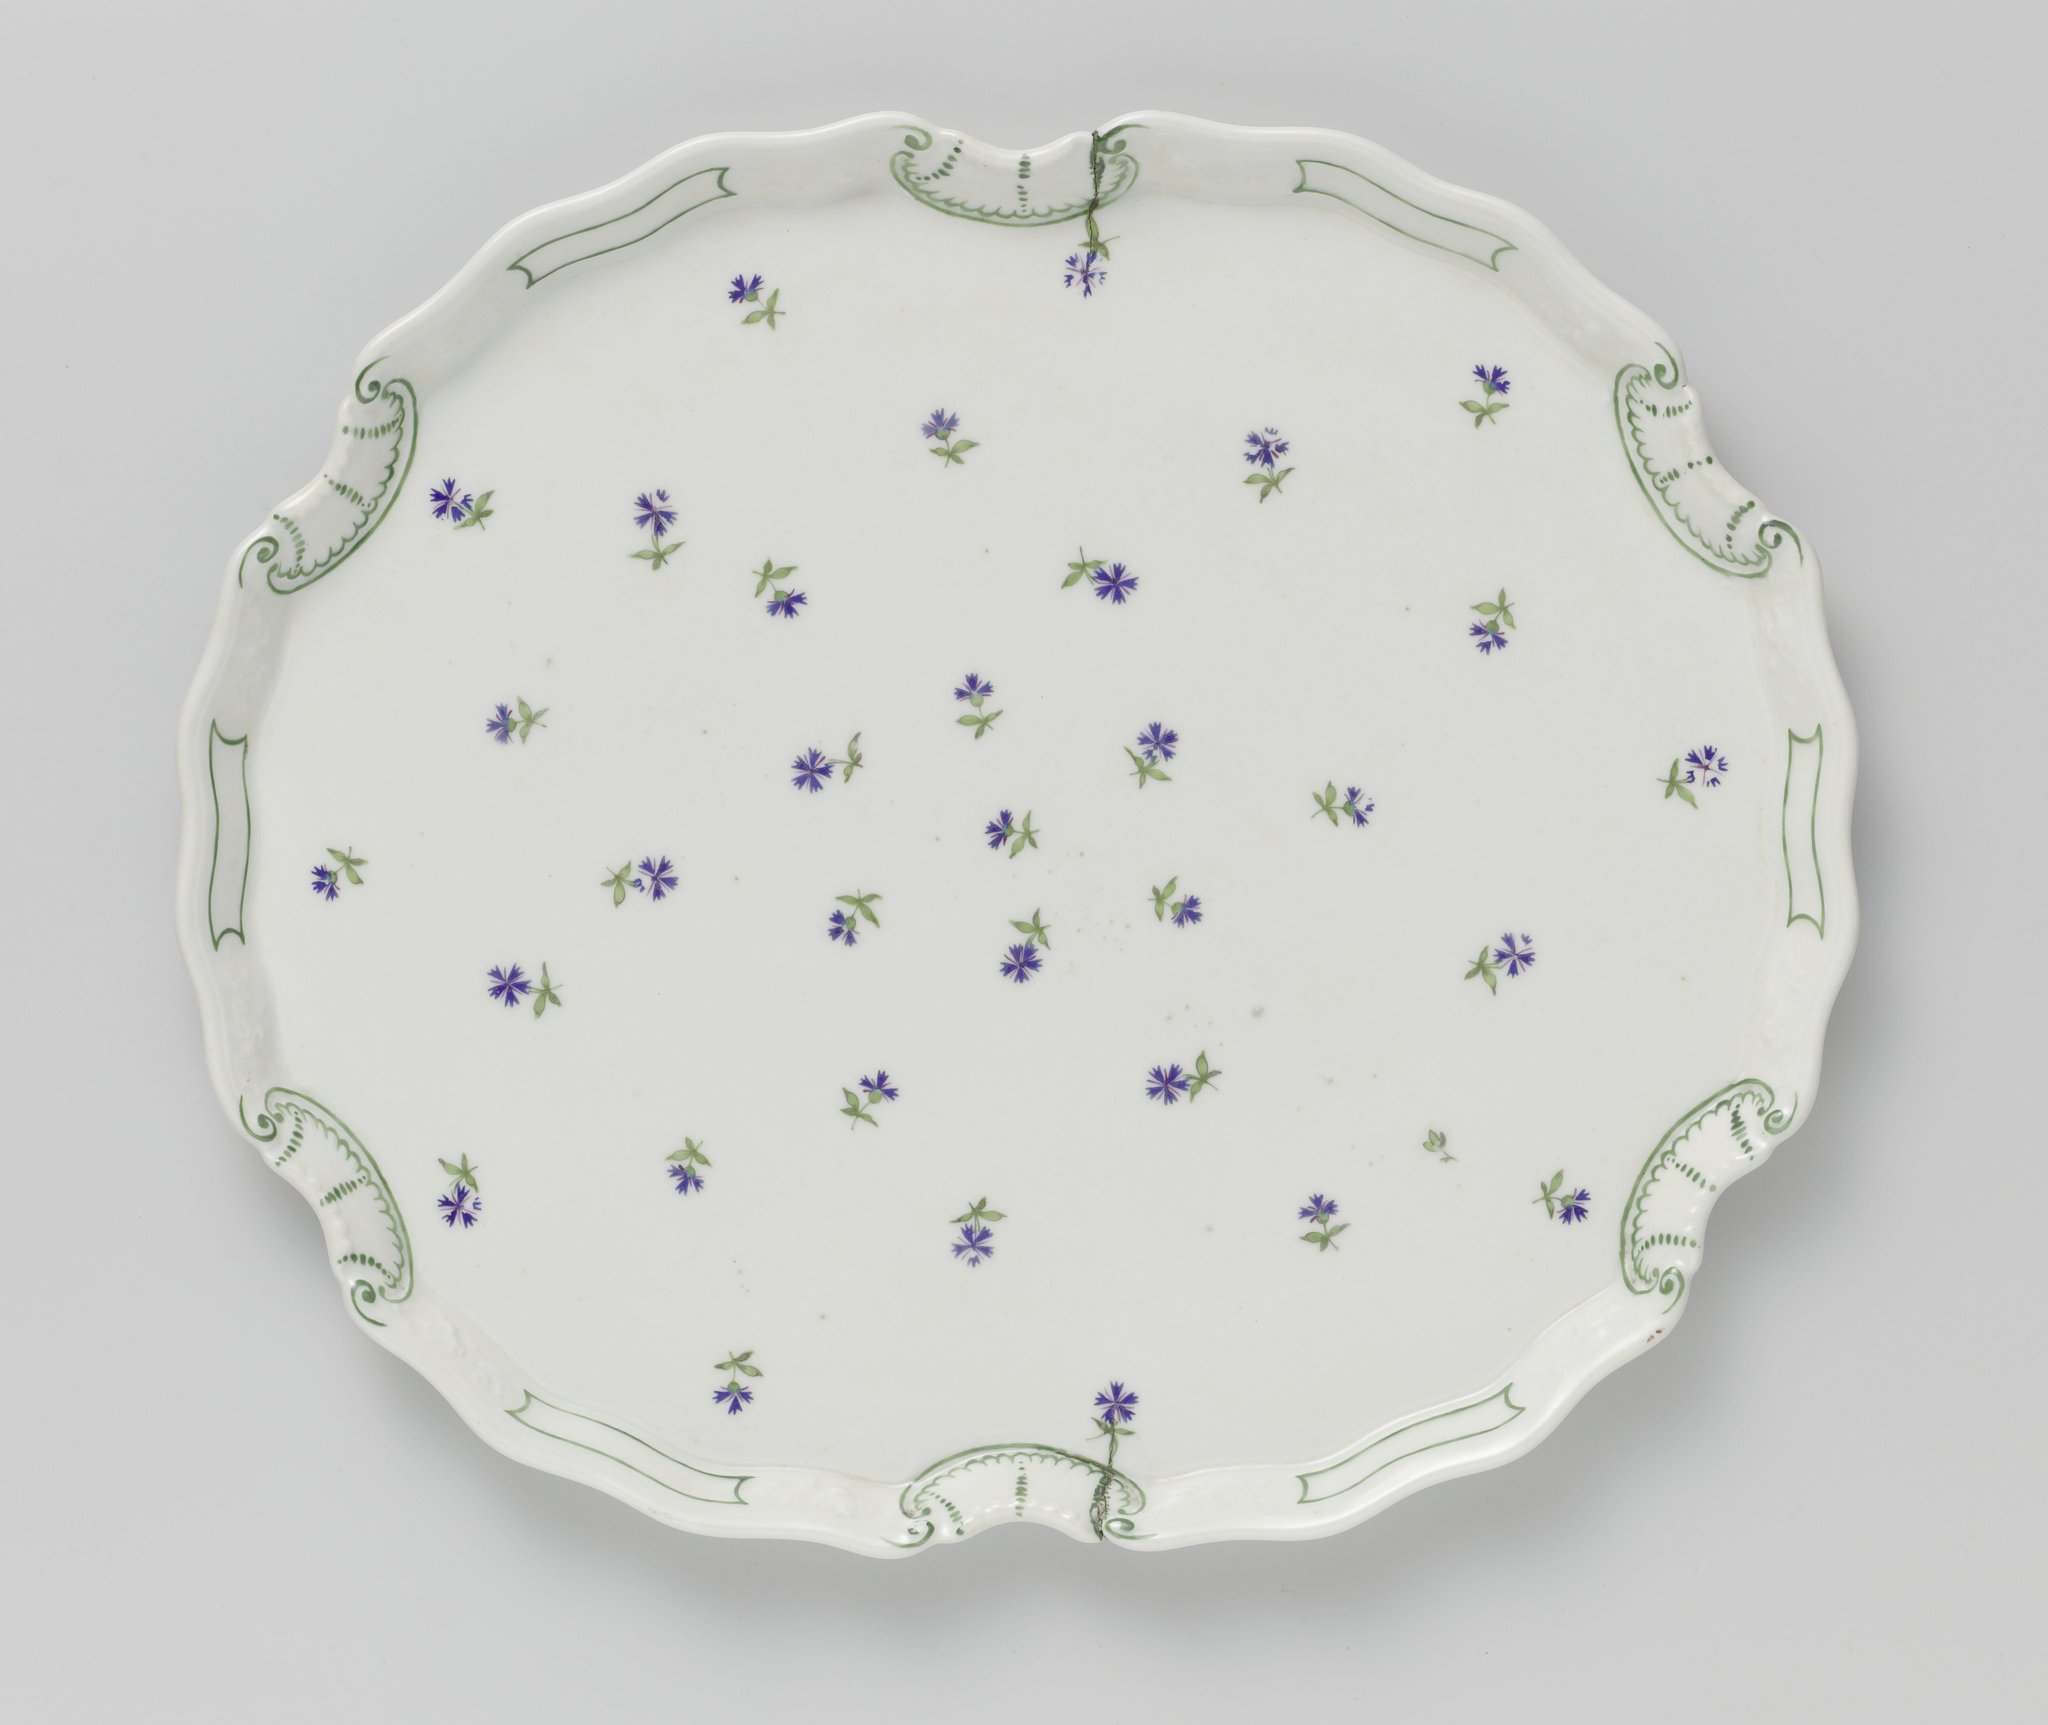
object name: blad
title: Blad, beschilderd met korenbloemen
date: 1784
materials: porcelain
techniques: painted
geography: loosdrecht